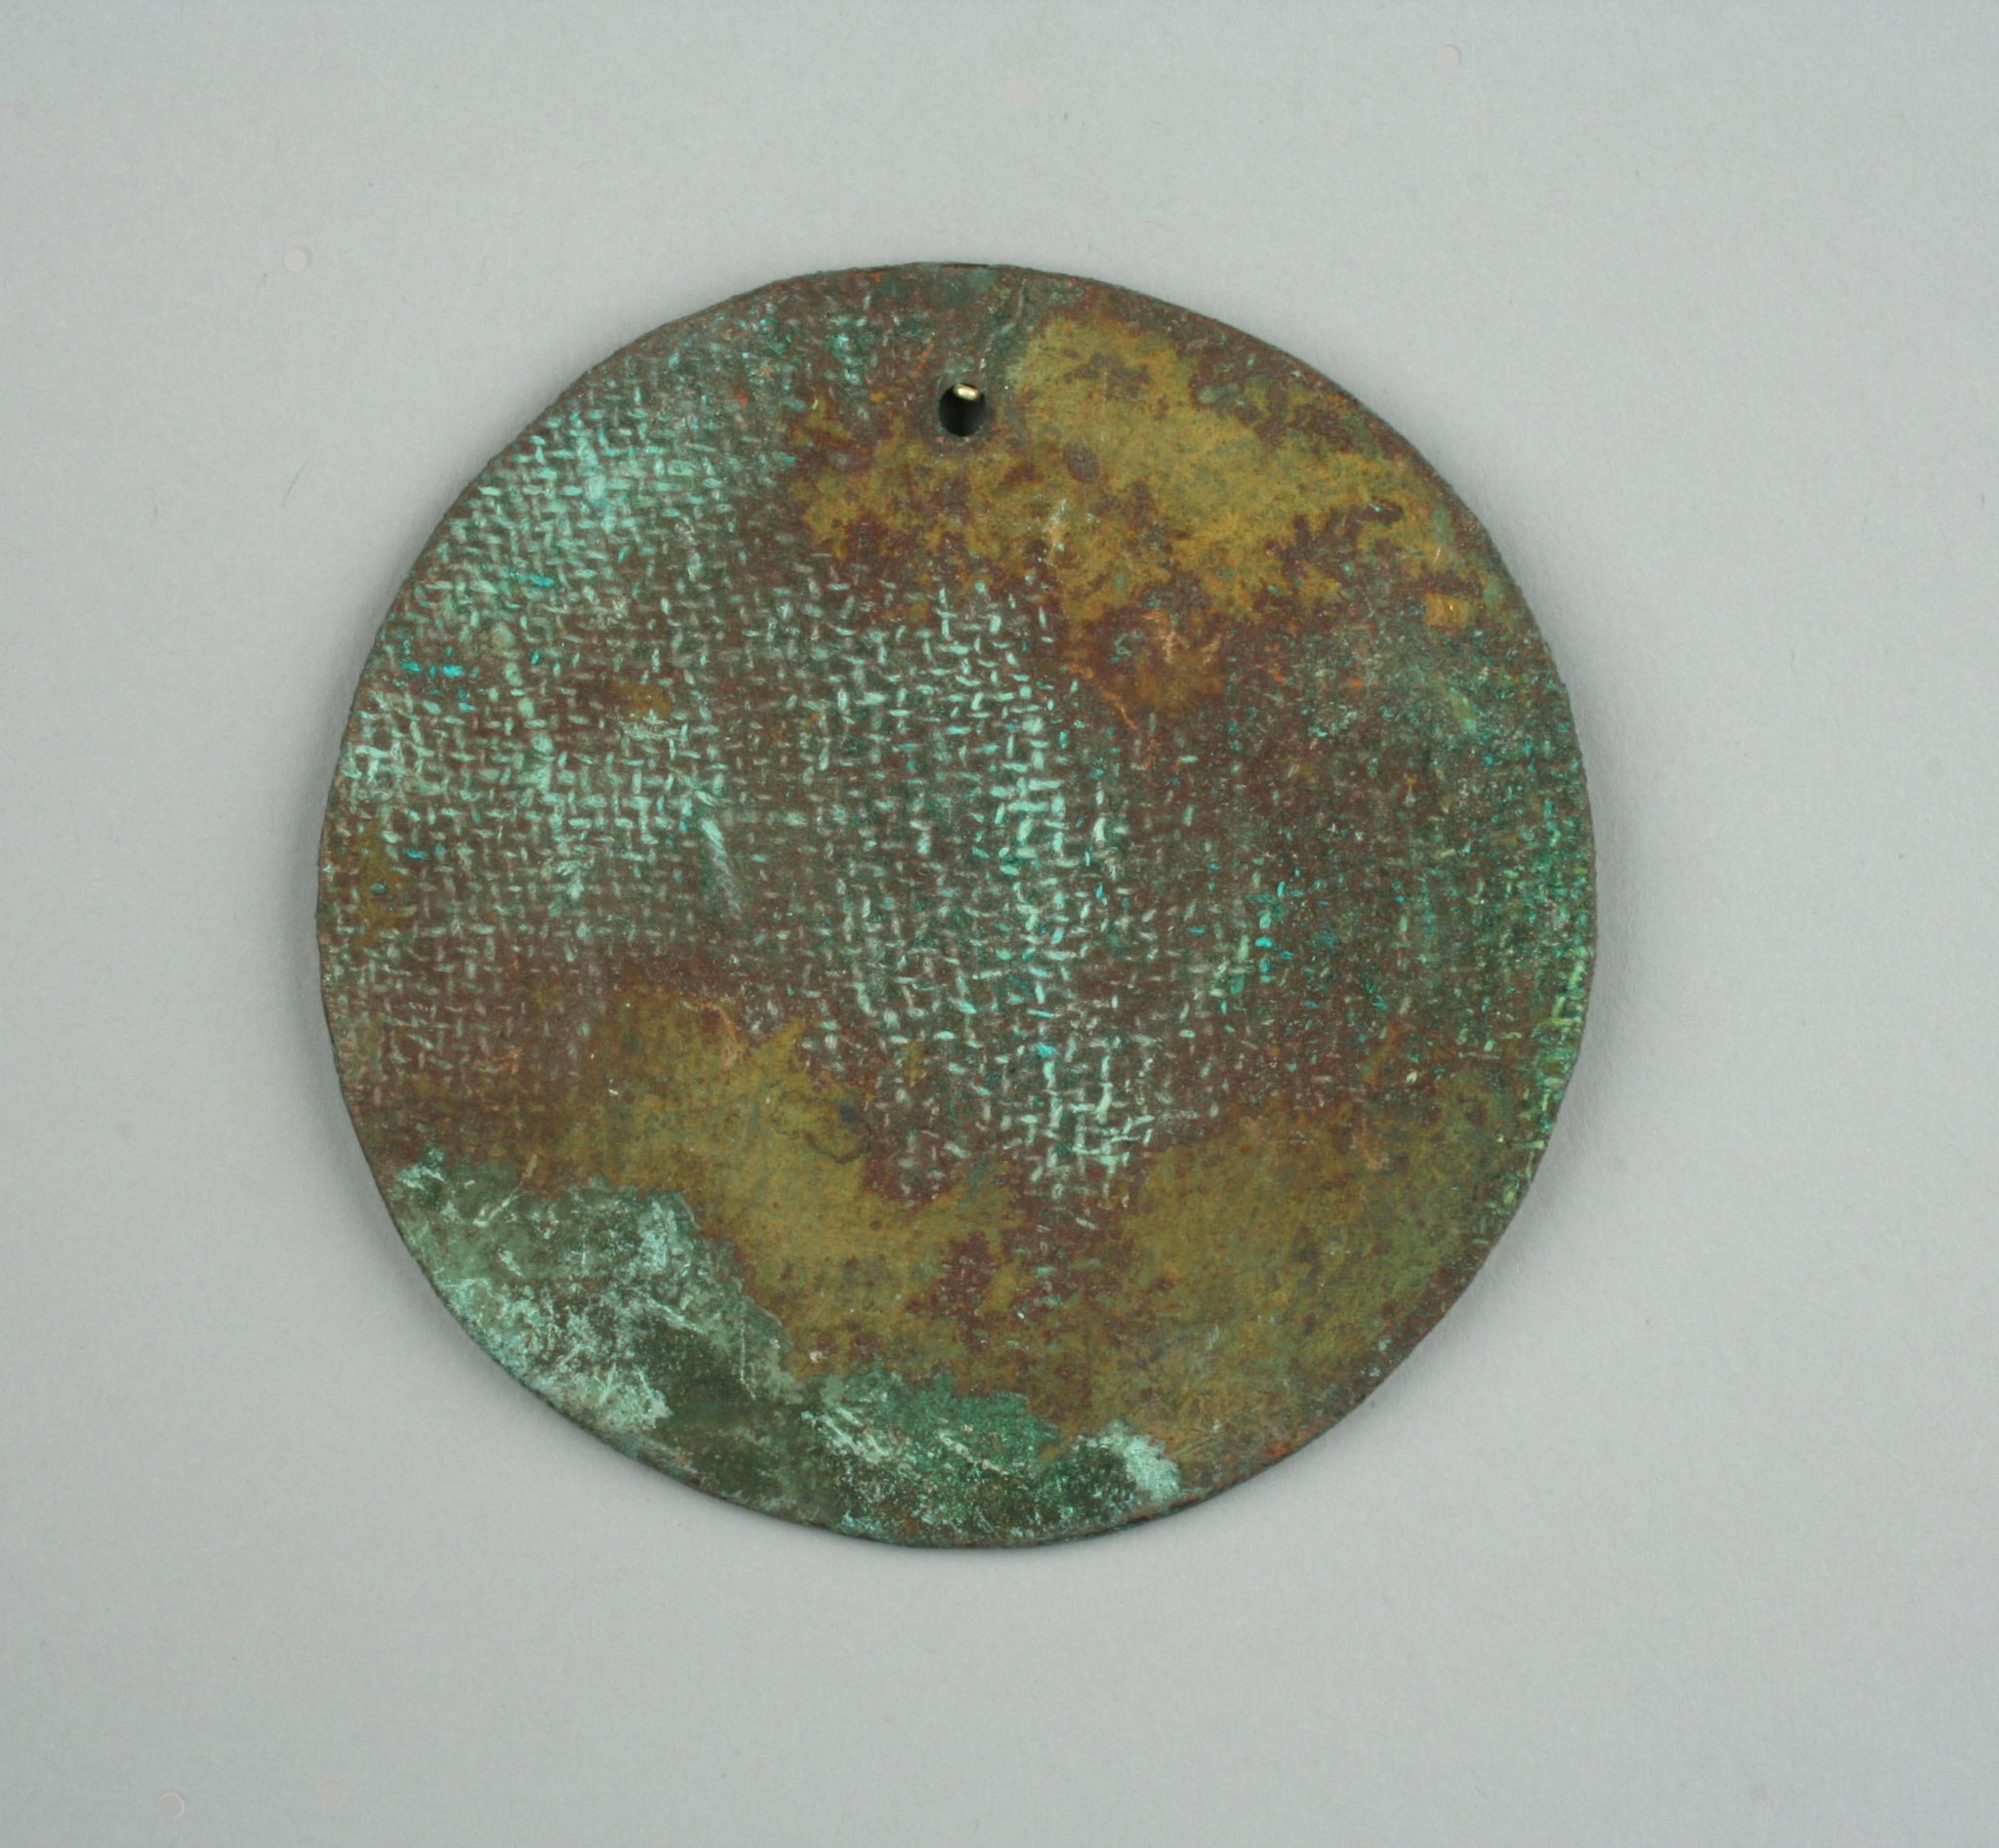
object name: plaque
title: Round Plaque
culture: vicús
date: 300 BCE-200 CE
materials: copper, gilt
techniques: hammering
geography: peru